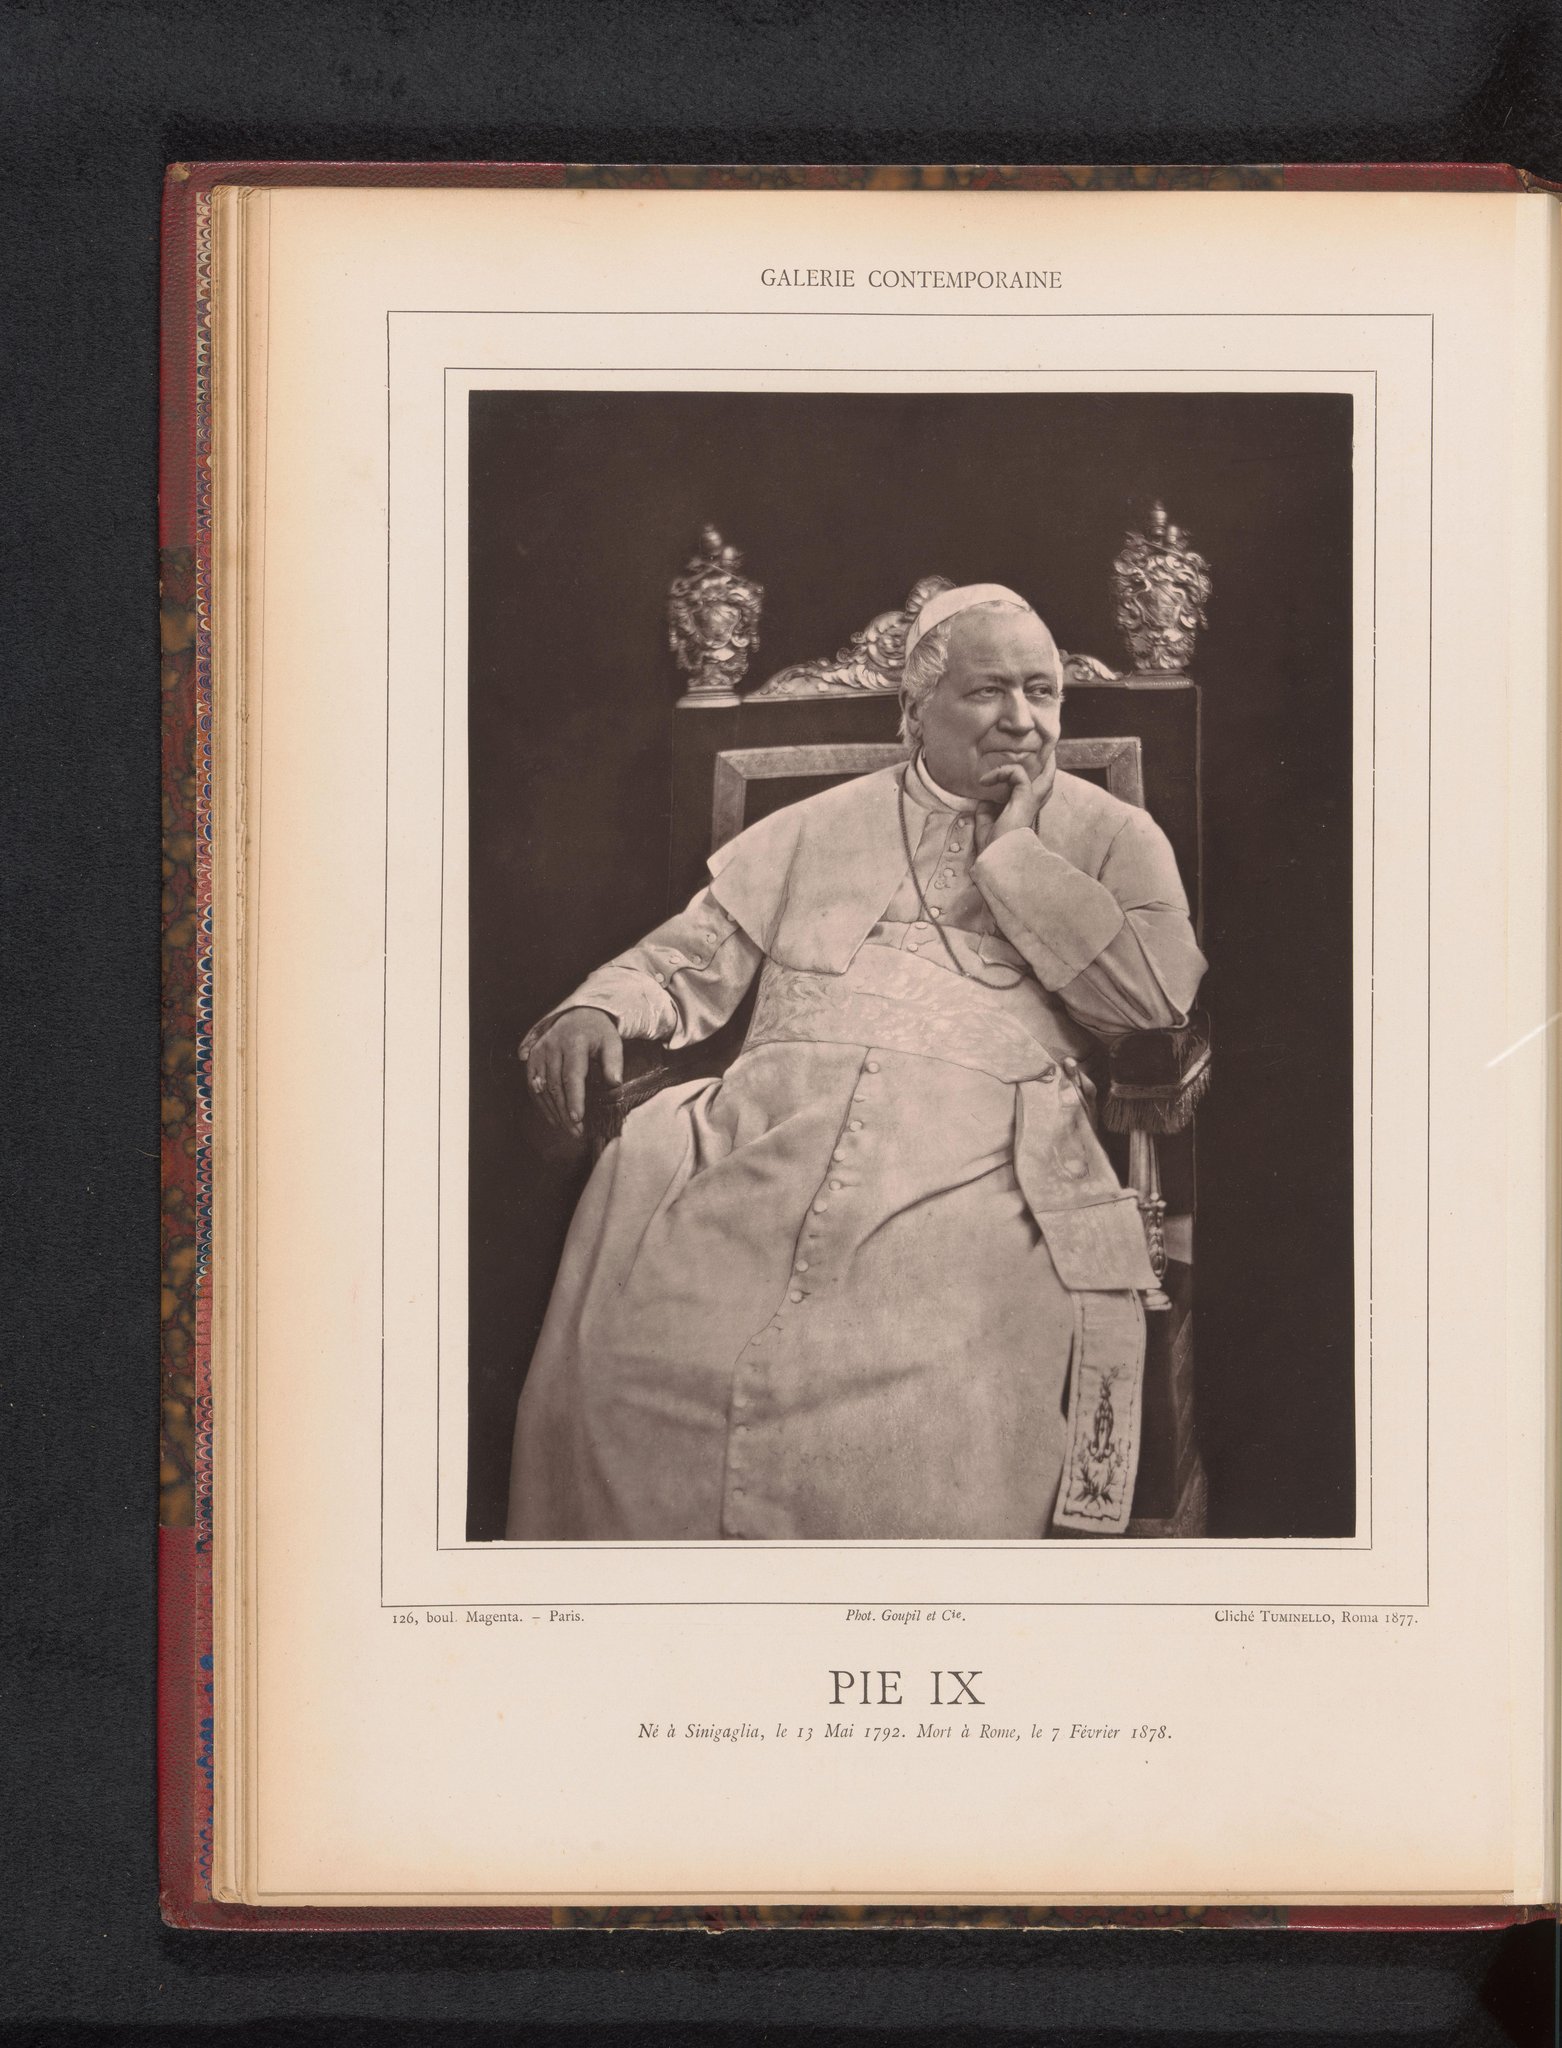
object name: photomechanical print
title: Portret van paus Pius IX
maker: ludovico tuminello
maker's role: fotograaf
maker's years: 1824-1907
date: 1873-1878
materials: paper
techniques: woodburytype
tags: rome, historical persons, pope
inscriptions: inscription: ‘Galerie contemporaine/ Né à Sinigaglia, le 13 Mai 1792. Mort à Rome, le 7 Février 1878.’